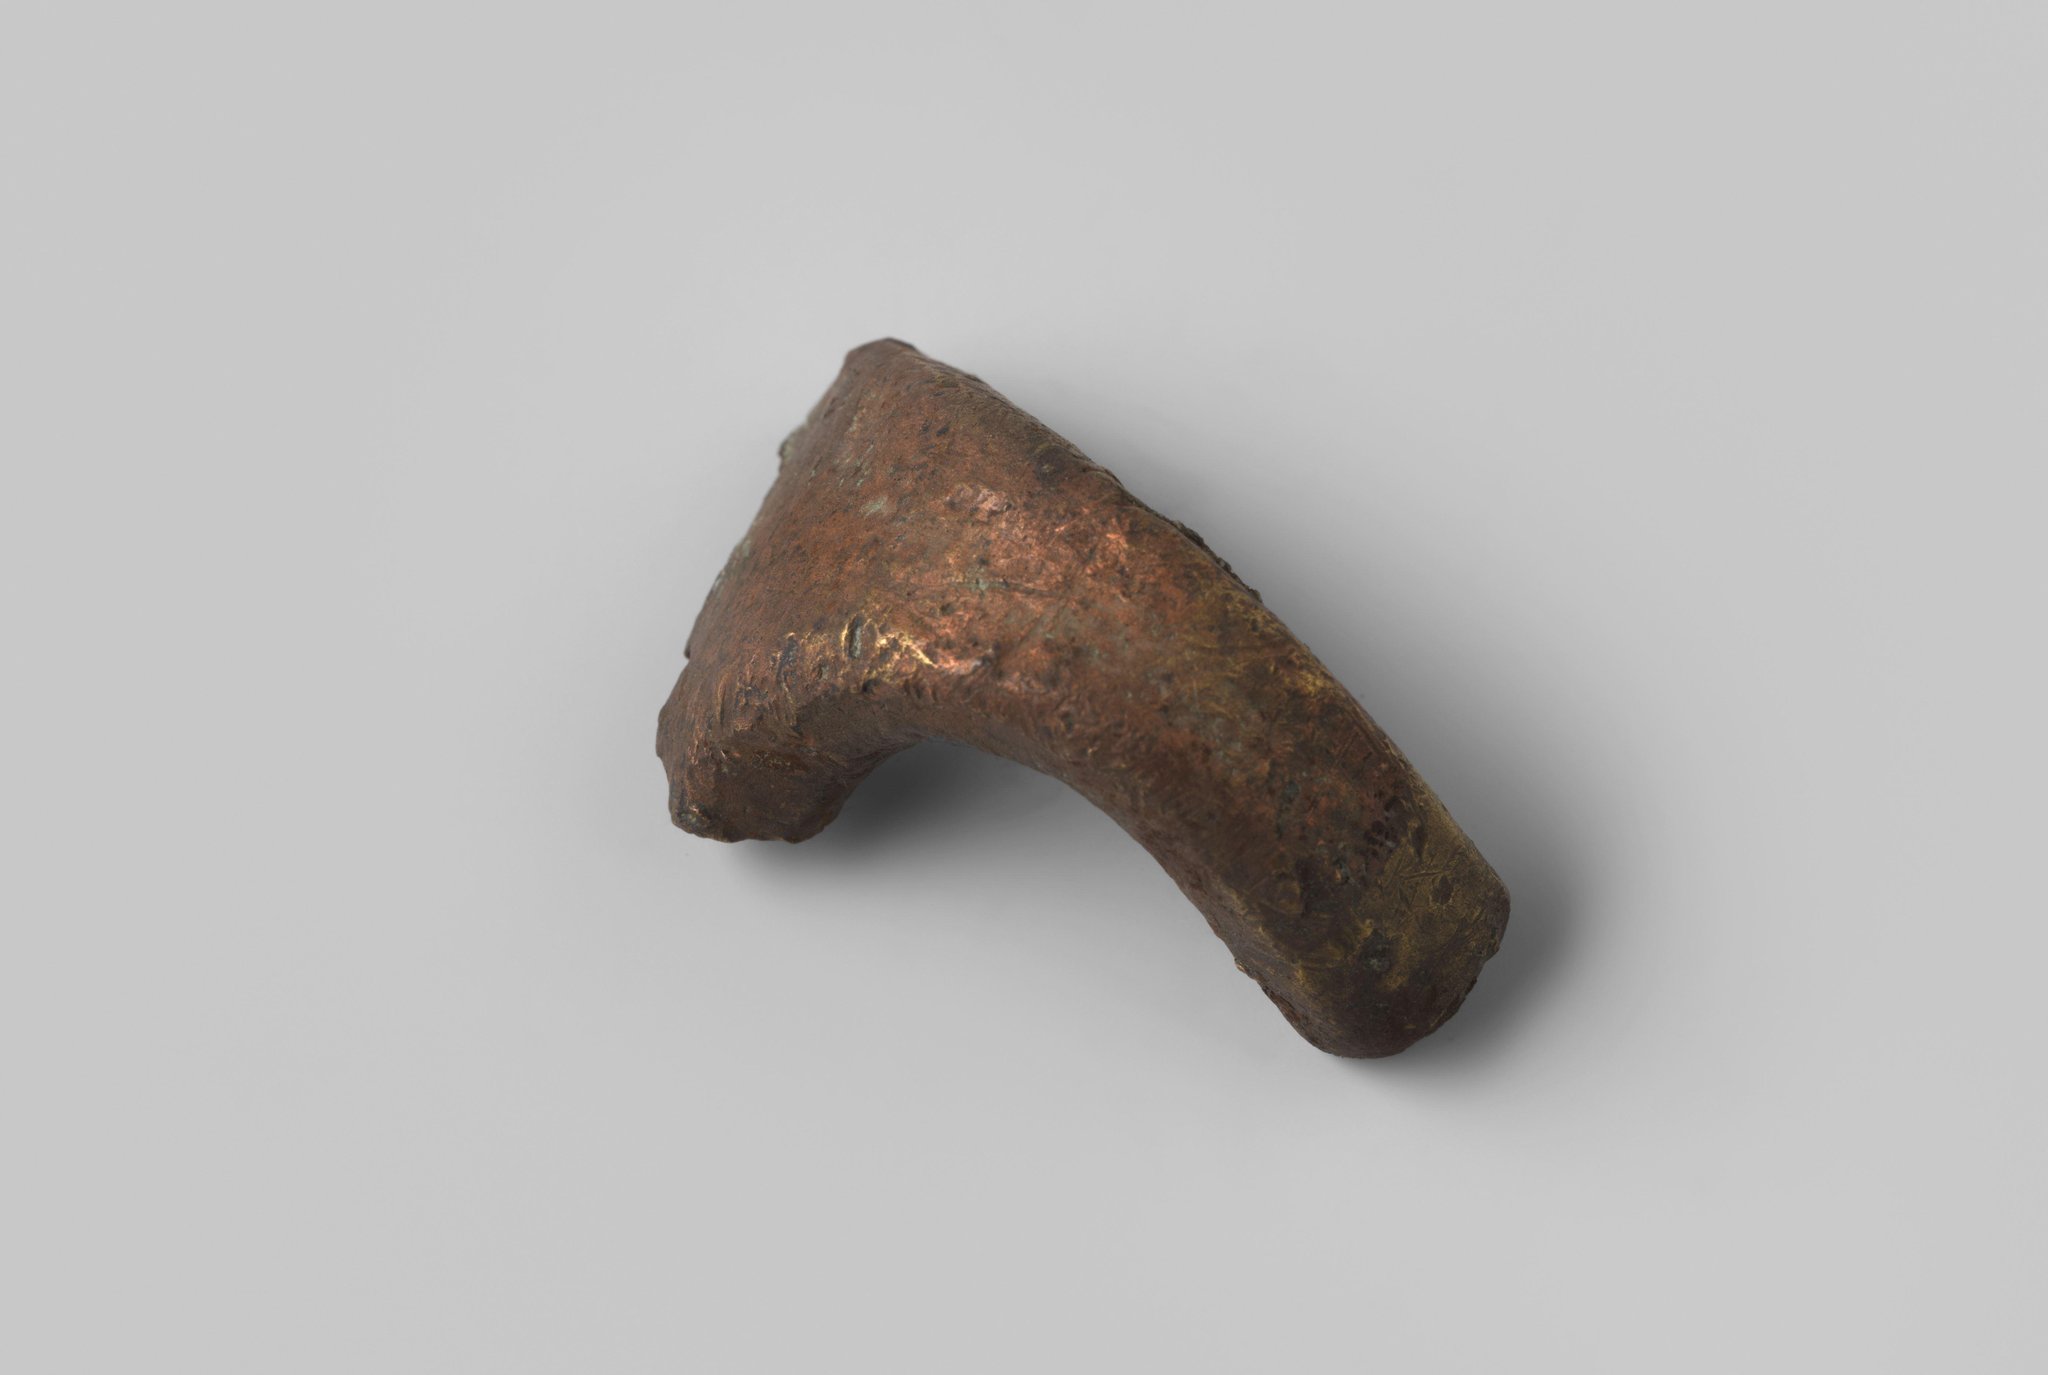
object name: koppelstuk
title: Fragment koppelstuk van een brandslang uit het wrak van de Oost-Indiëvaarder Hollandia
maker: Anonymous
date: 1700-1743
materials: copper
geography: netherlands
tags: verenigde oostindische compagnie, hollandia (schip), annet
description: Fire engine, firehose coupling; fragment, loop id. NG 1978-29H649.